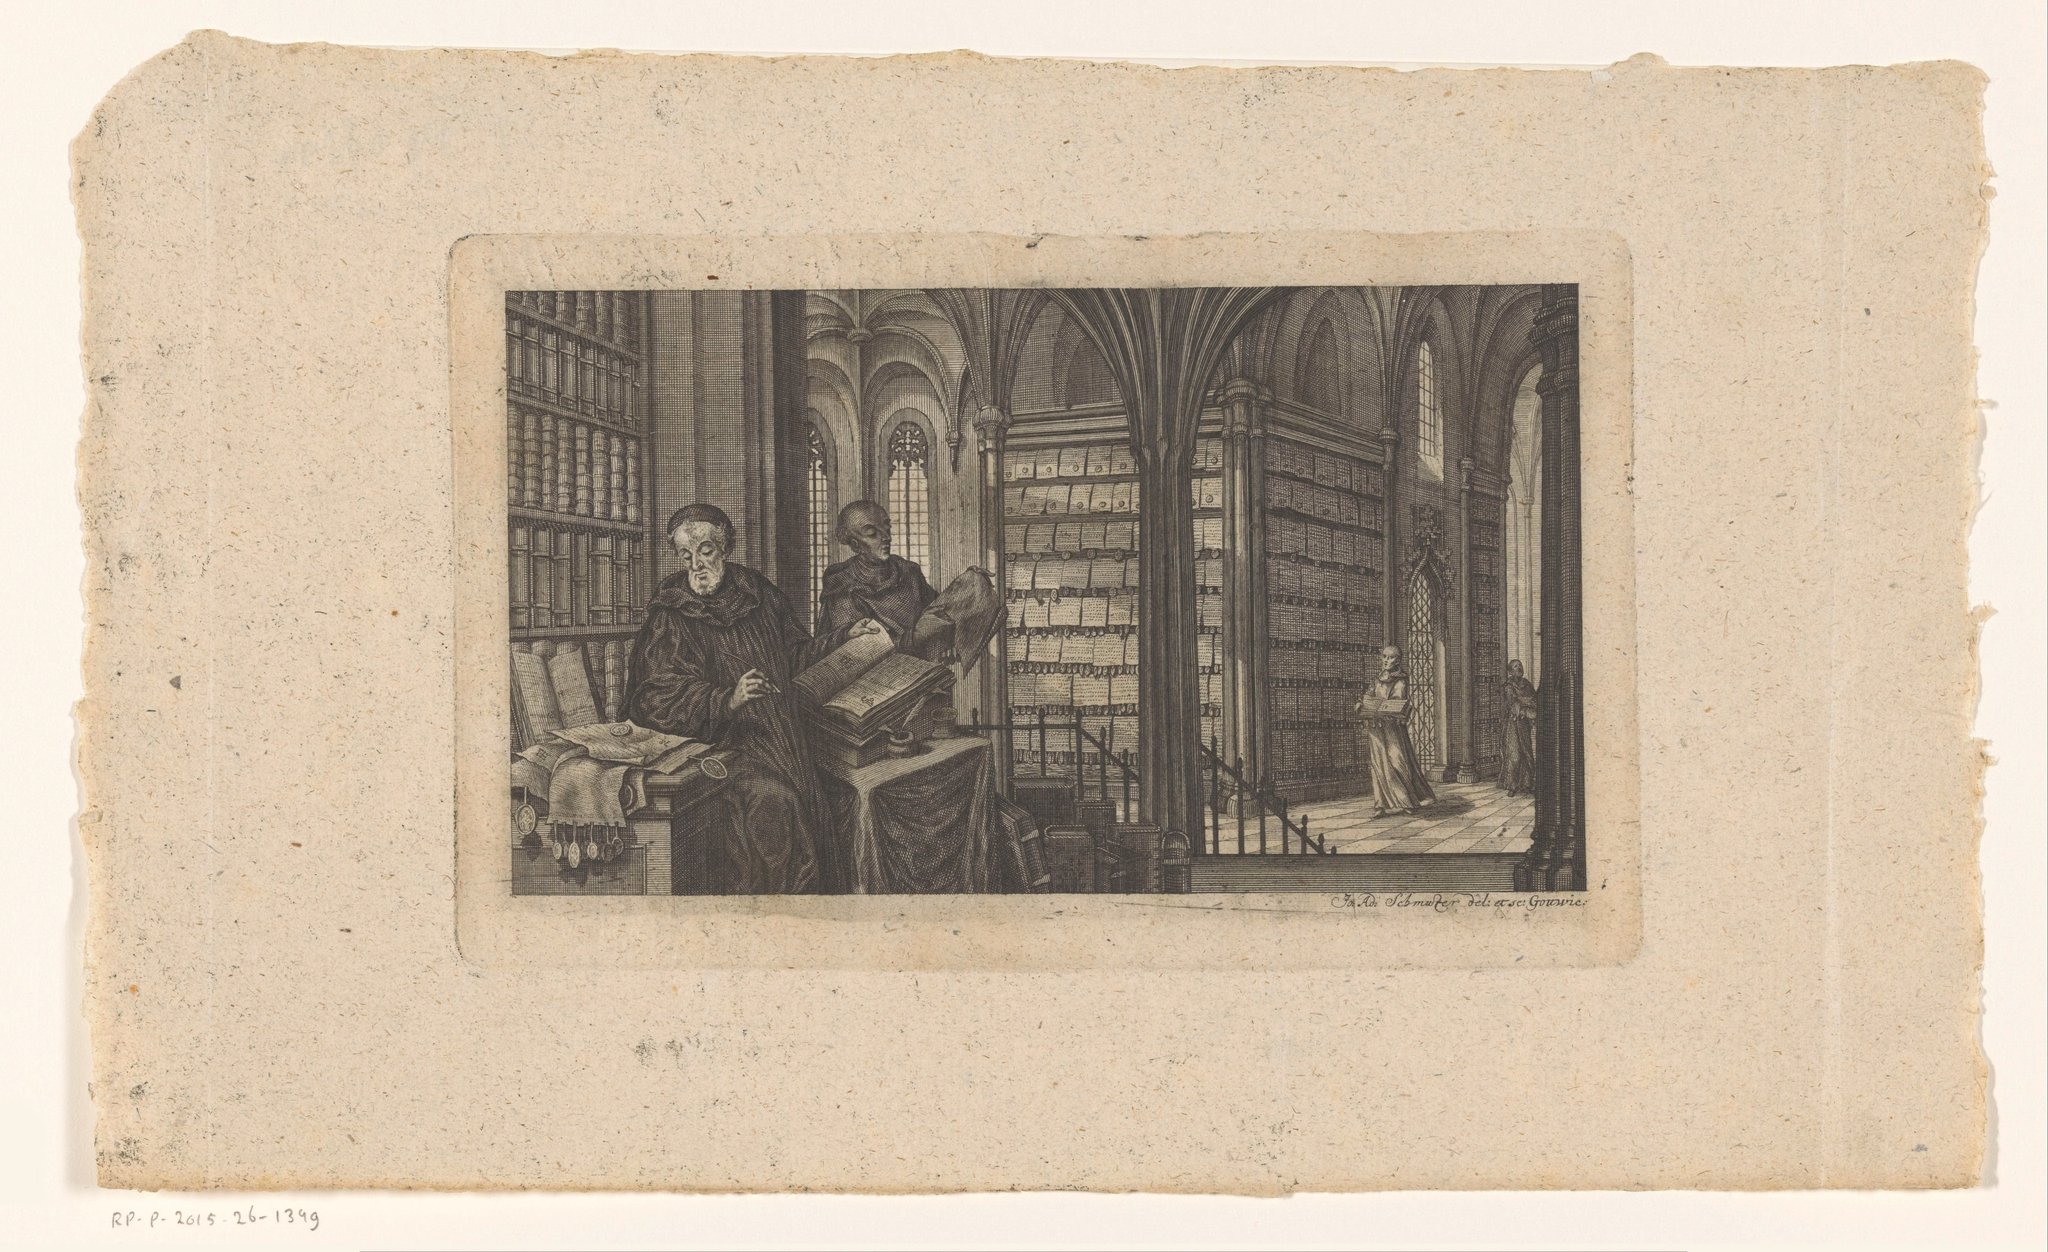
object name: print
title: Abdij Göttweig in Oostenrijk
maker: johann adam schmutzer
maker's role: print maker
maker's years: 1680-1739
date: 1690-1739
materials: paper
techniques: engraving, etching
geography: göttweig abbey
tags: abbey, monastery, convent ~ roman catholic church, public library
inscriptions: collector's mark: Lugt 4779, collector's mark: Lugt 2228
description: Voor een boekenkast zijn twee kloosterlingen bezig met het overschrijven van oorkondes in een boek. In de kloostergang daarachter loopt een kloosterling met een opengeslagen boek in zijn handen. De hoek van de gang hangt volg met oorkondes.